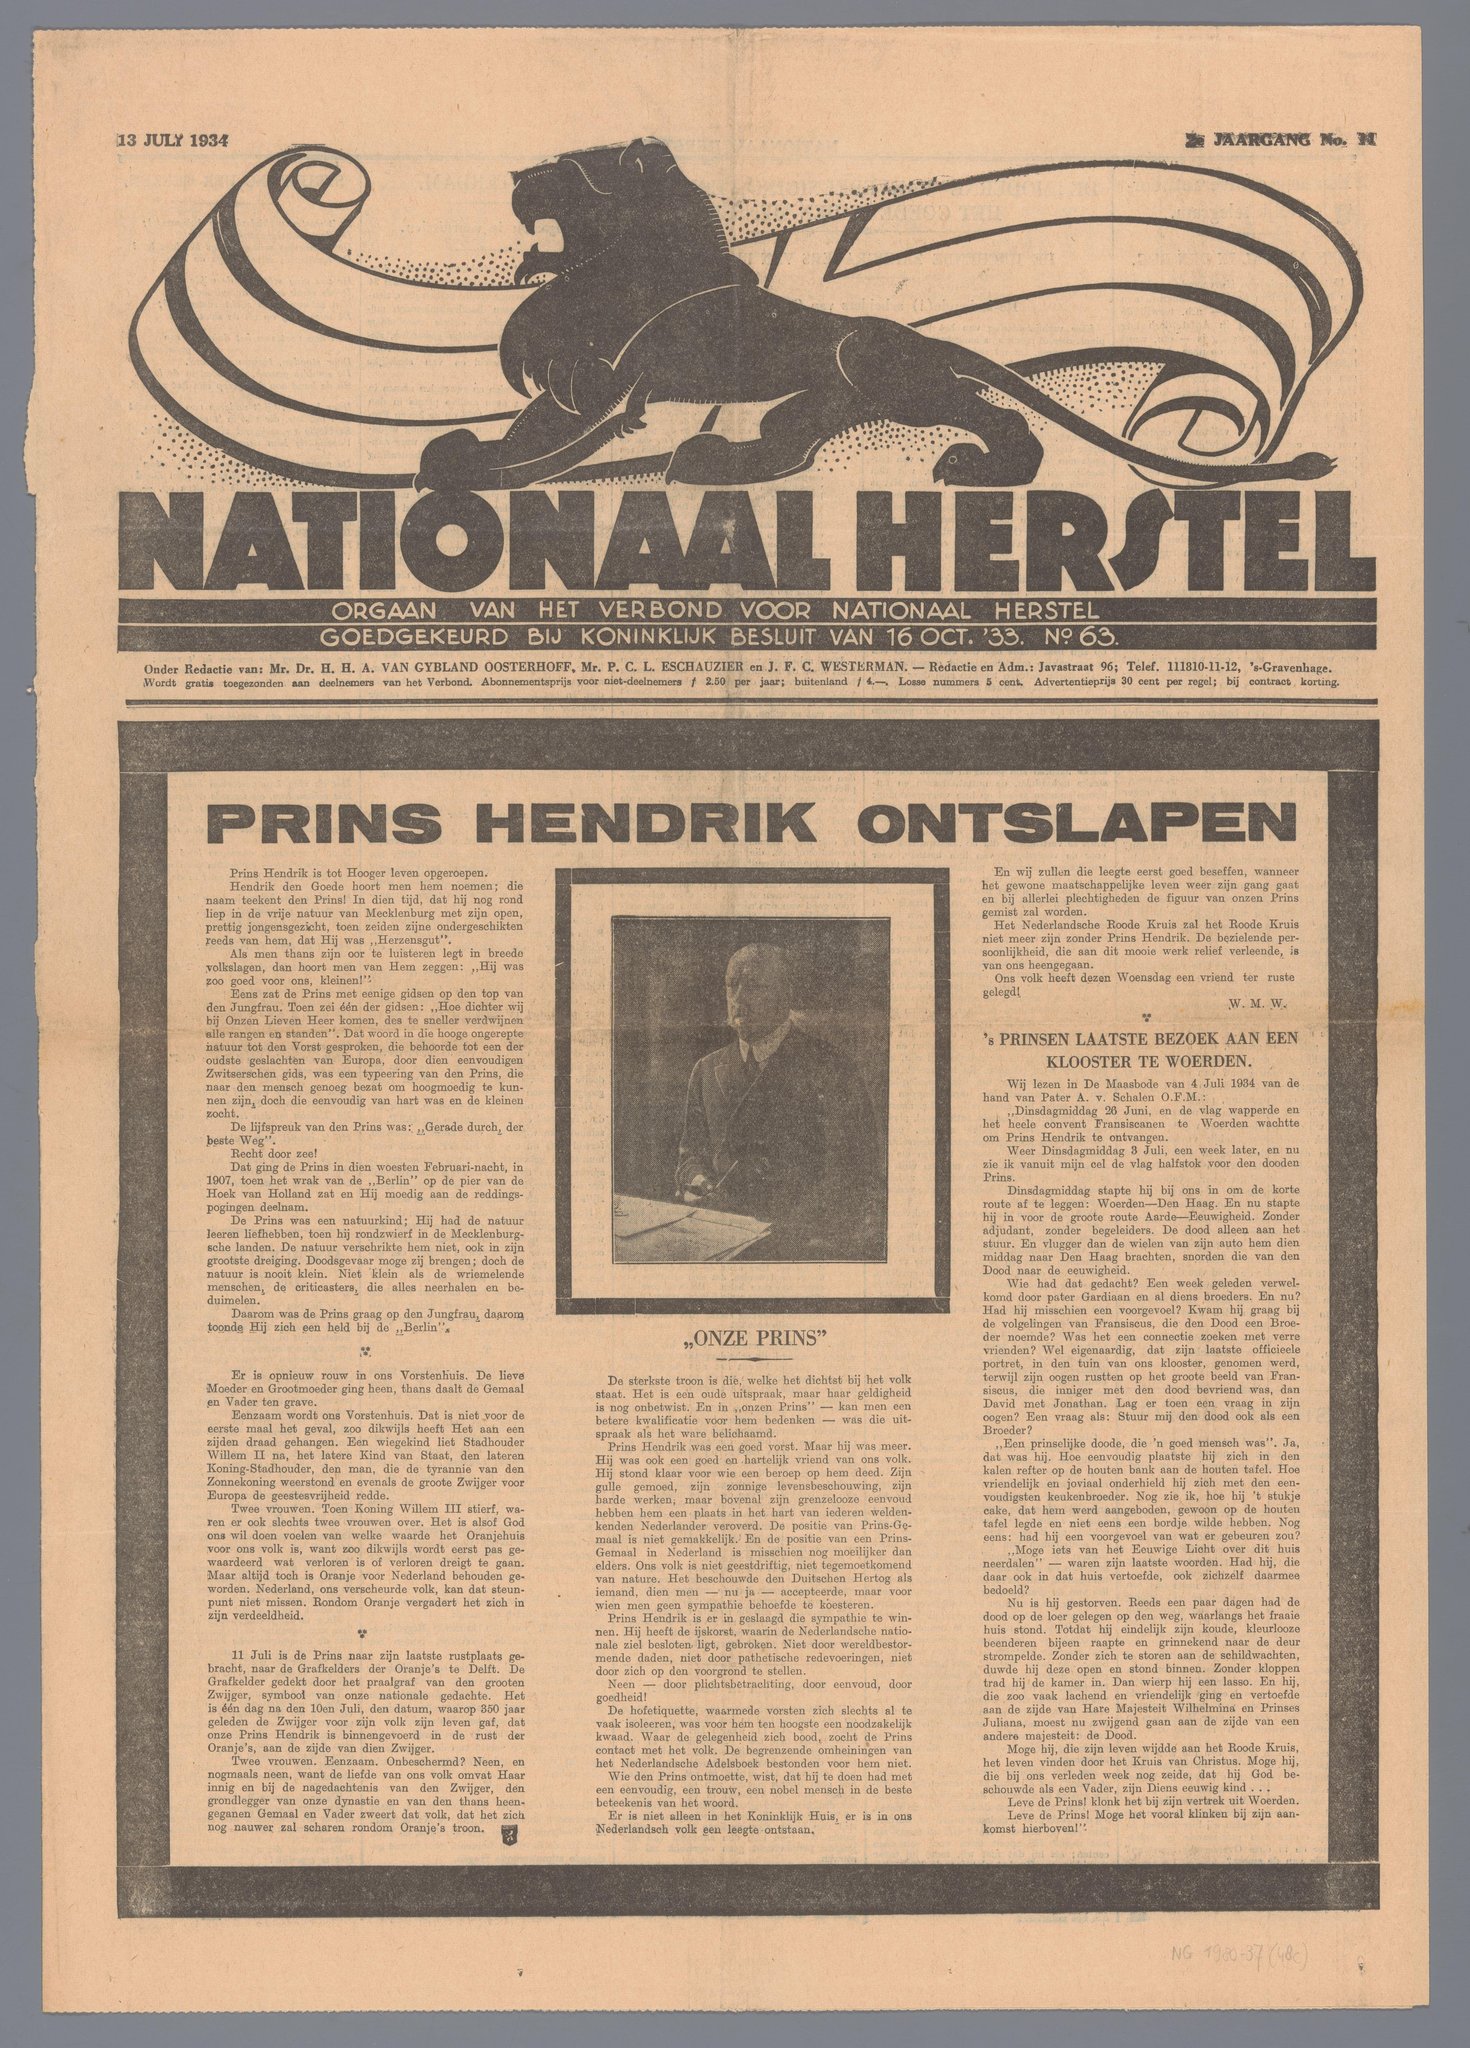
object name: newspaper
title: Nationaal Herstel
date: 1934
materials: paper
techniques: printing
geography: the hague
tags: the hague, hendrik (prins der nederlanden (1876-1934)), netherlands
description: Krant over het overlijden van prins Hendrik, nr. 11 van de 2de jaargang van de "Nationaal Herstel", 4pp voorpagina zwart omkaderd.